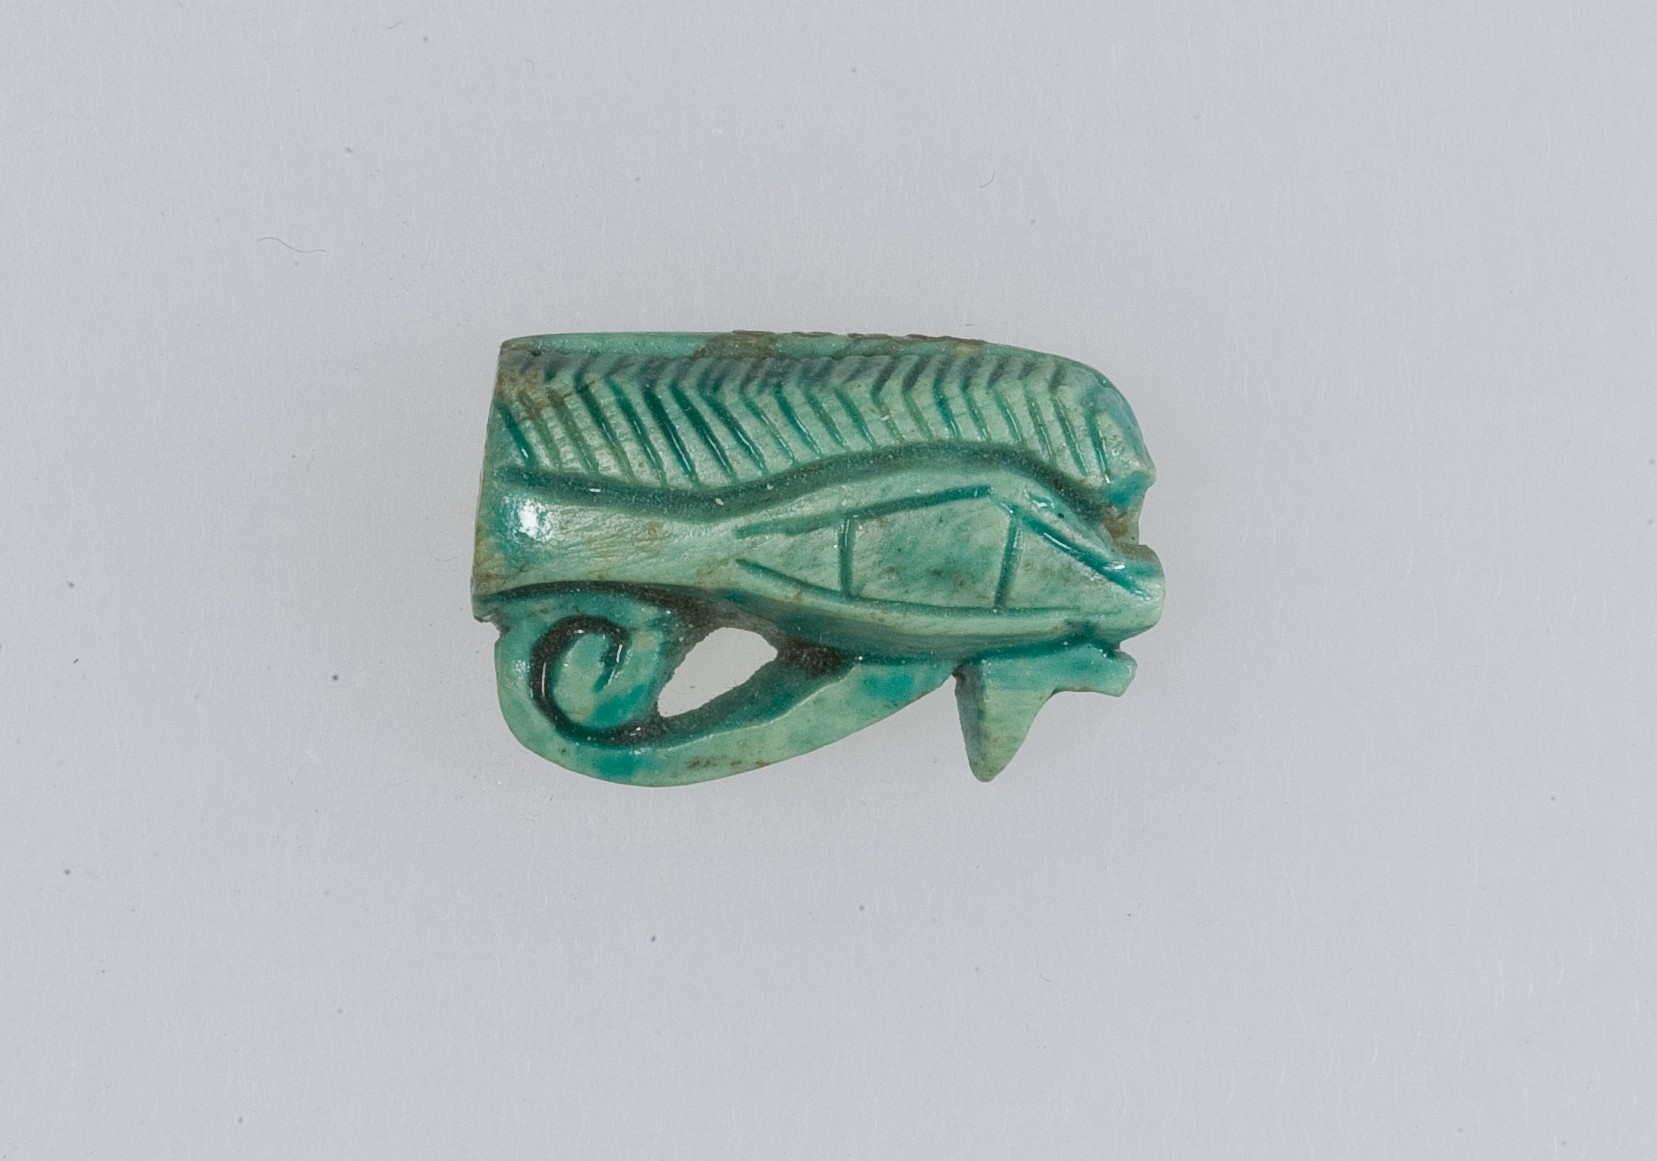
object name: wedjat eye, thutmose iv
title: Stamp Seal in the Shape of Wedjat-Eye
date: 1400-1390 BCE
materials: stone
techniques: glazing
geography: egypt